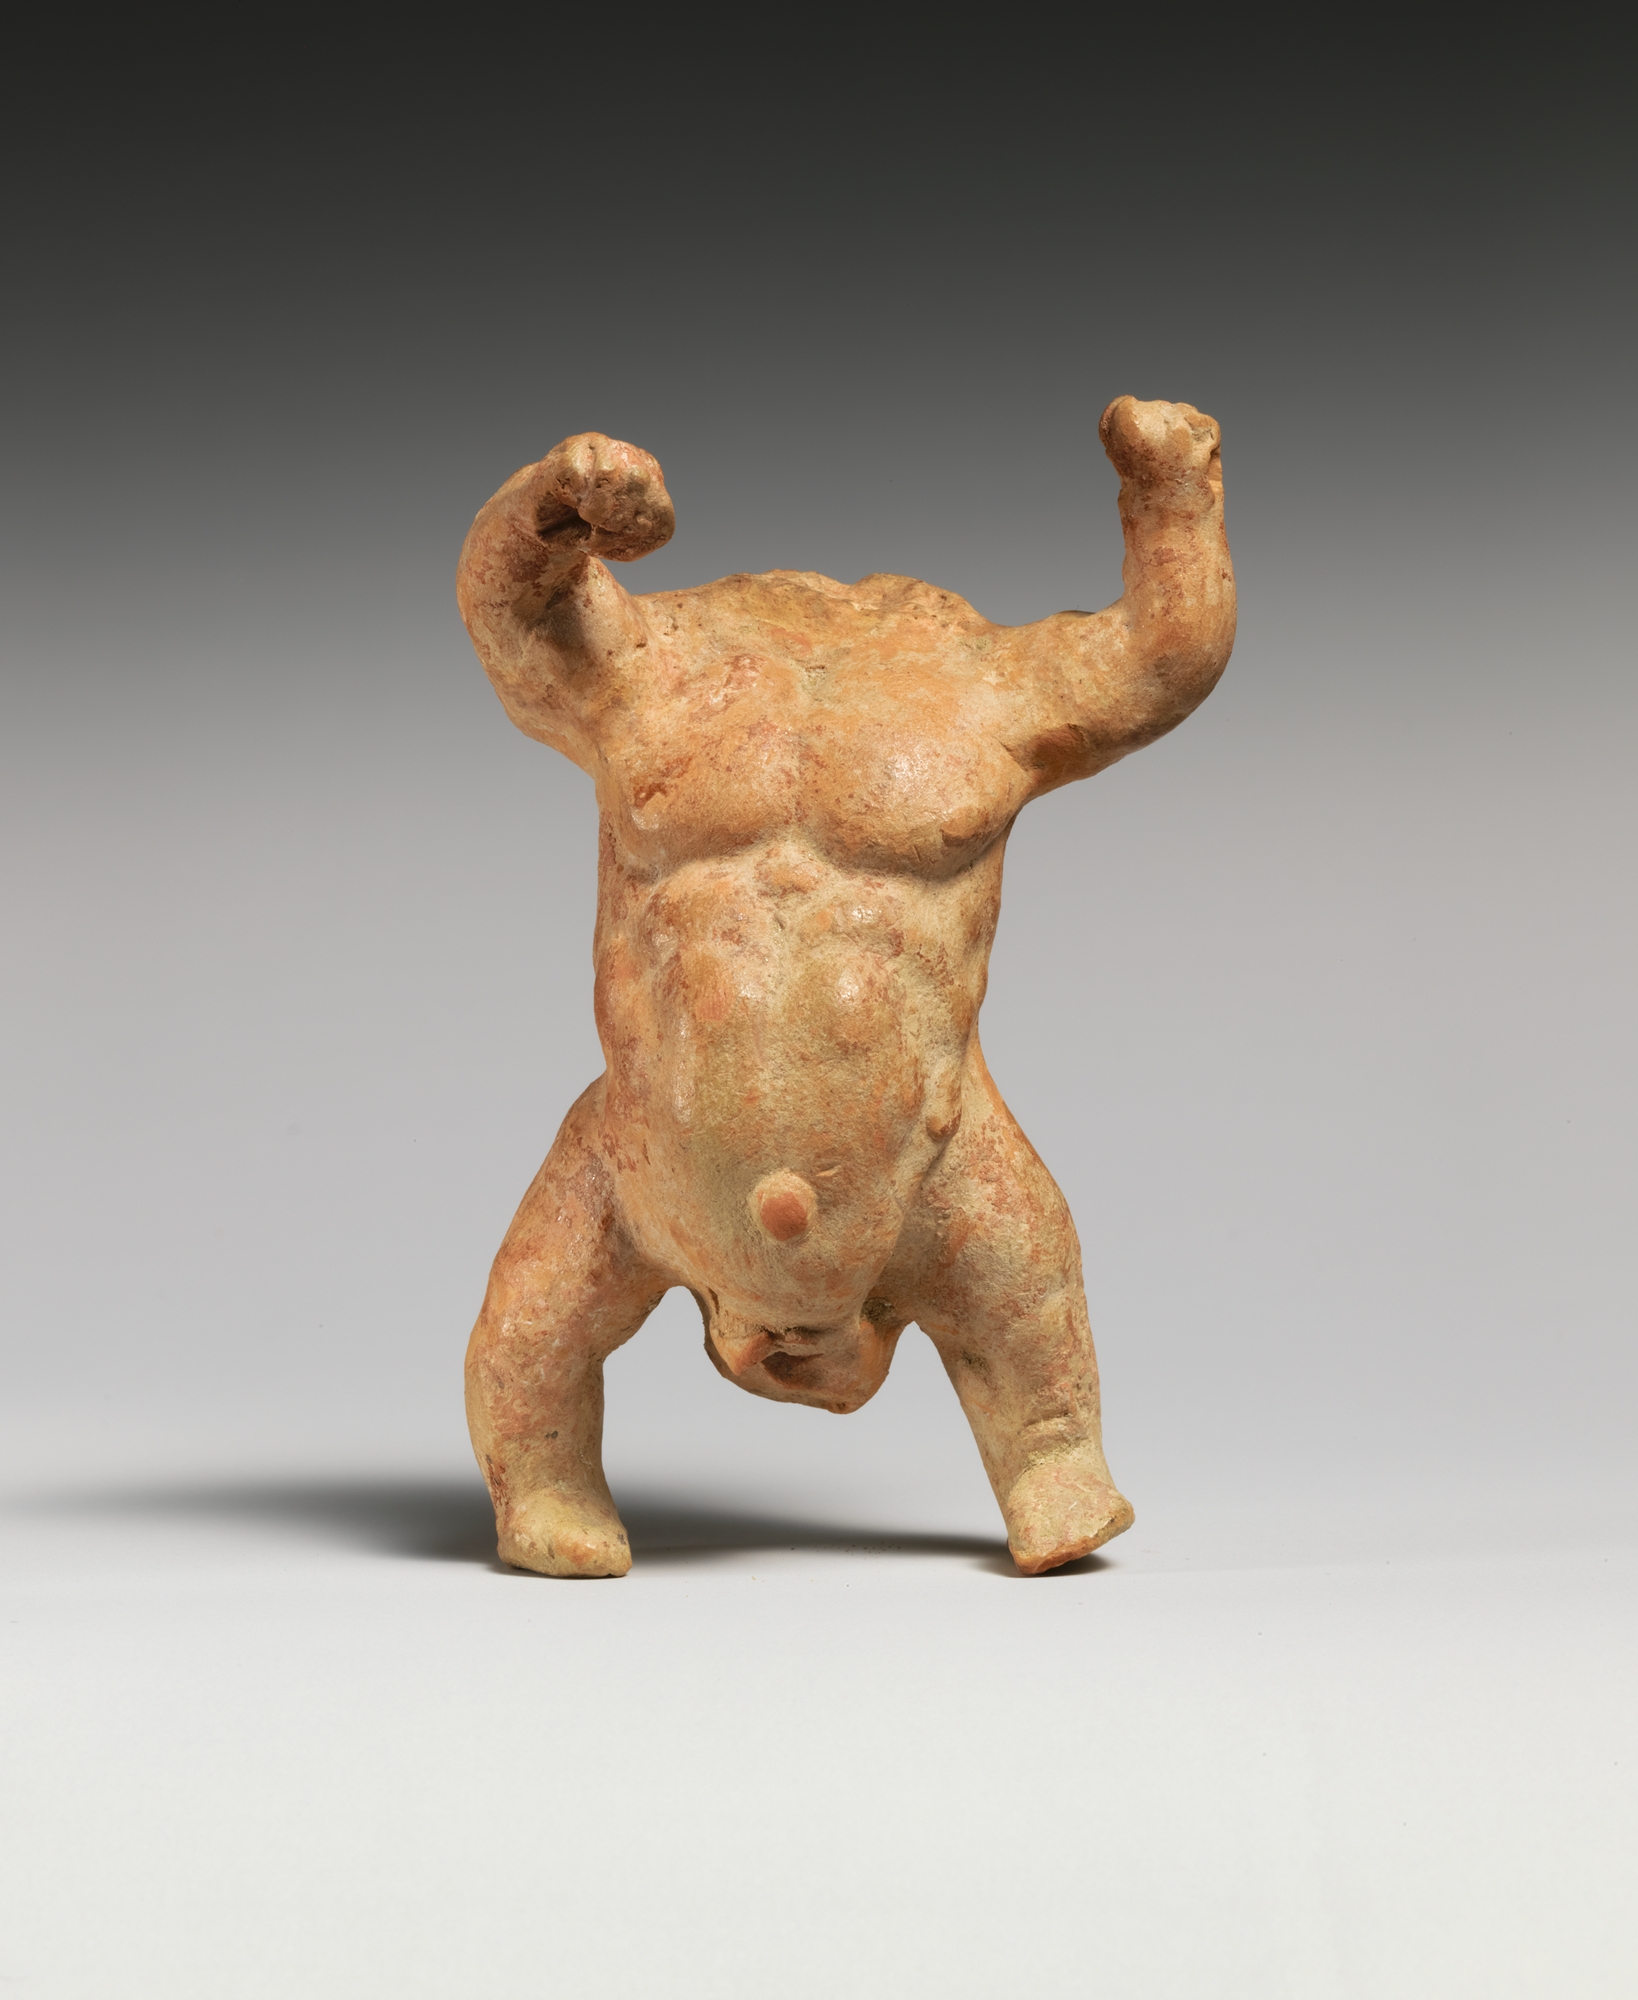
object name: statuette, dwarf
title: Terracotta Statuette of a Male Dwarf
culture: greek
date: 200-101 BCE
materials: terracotta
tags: men